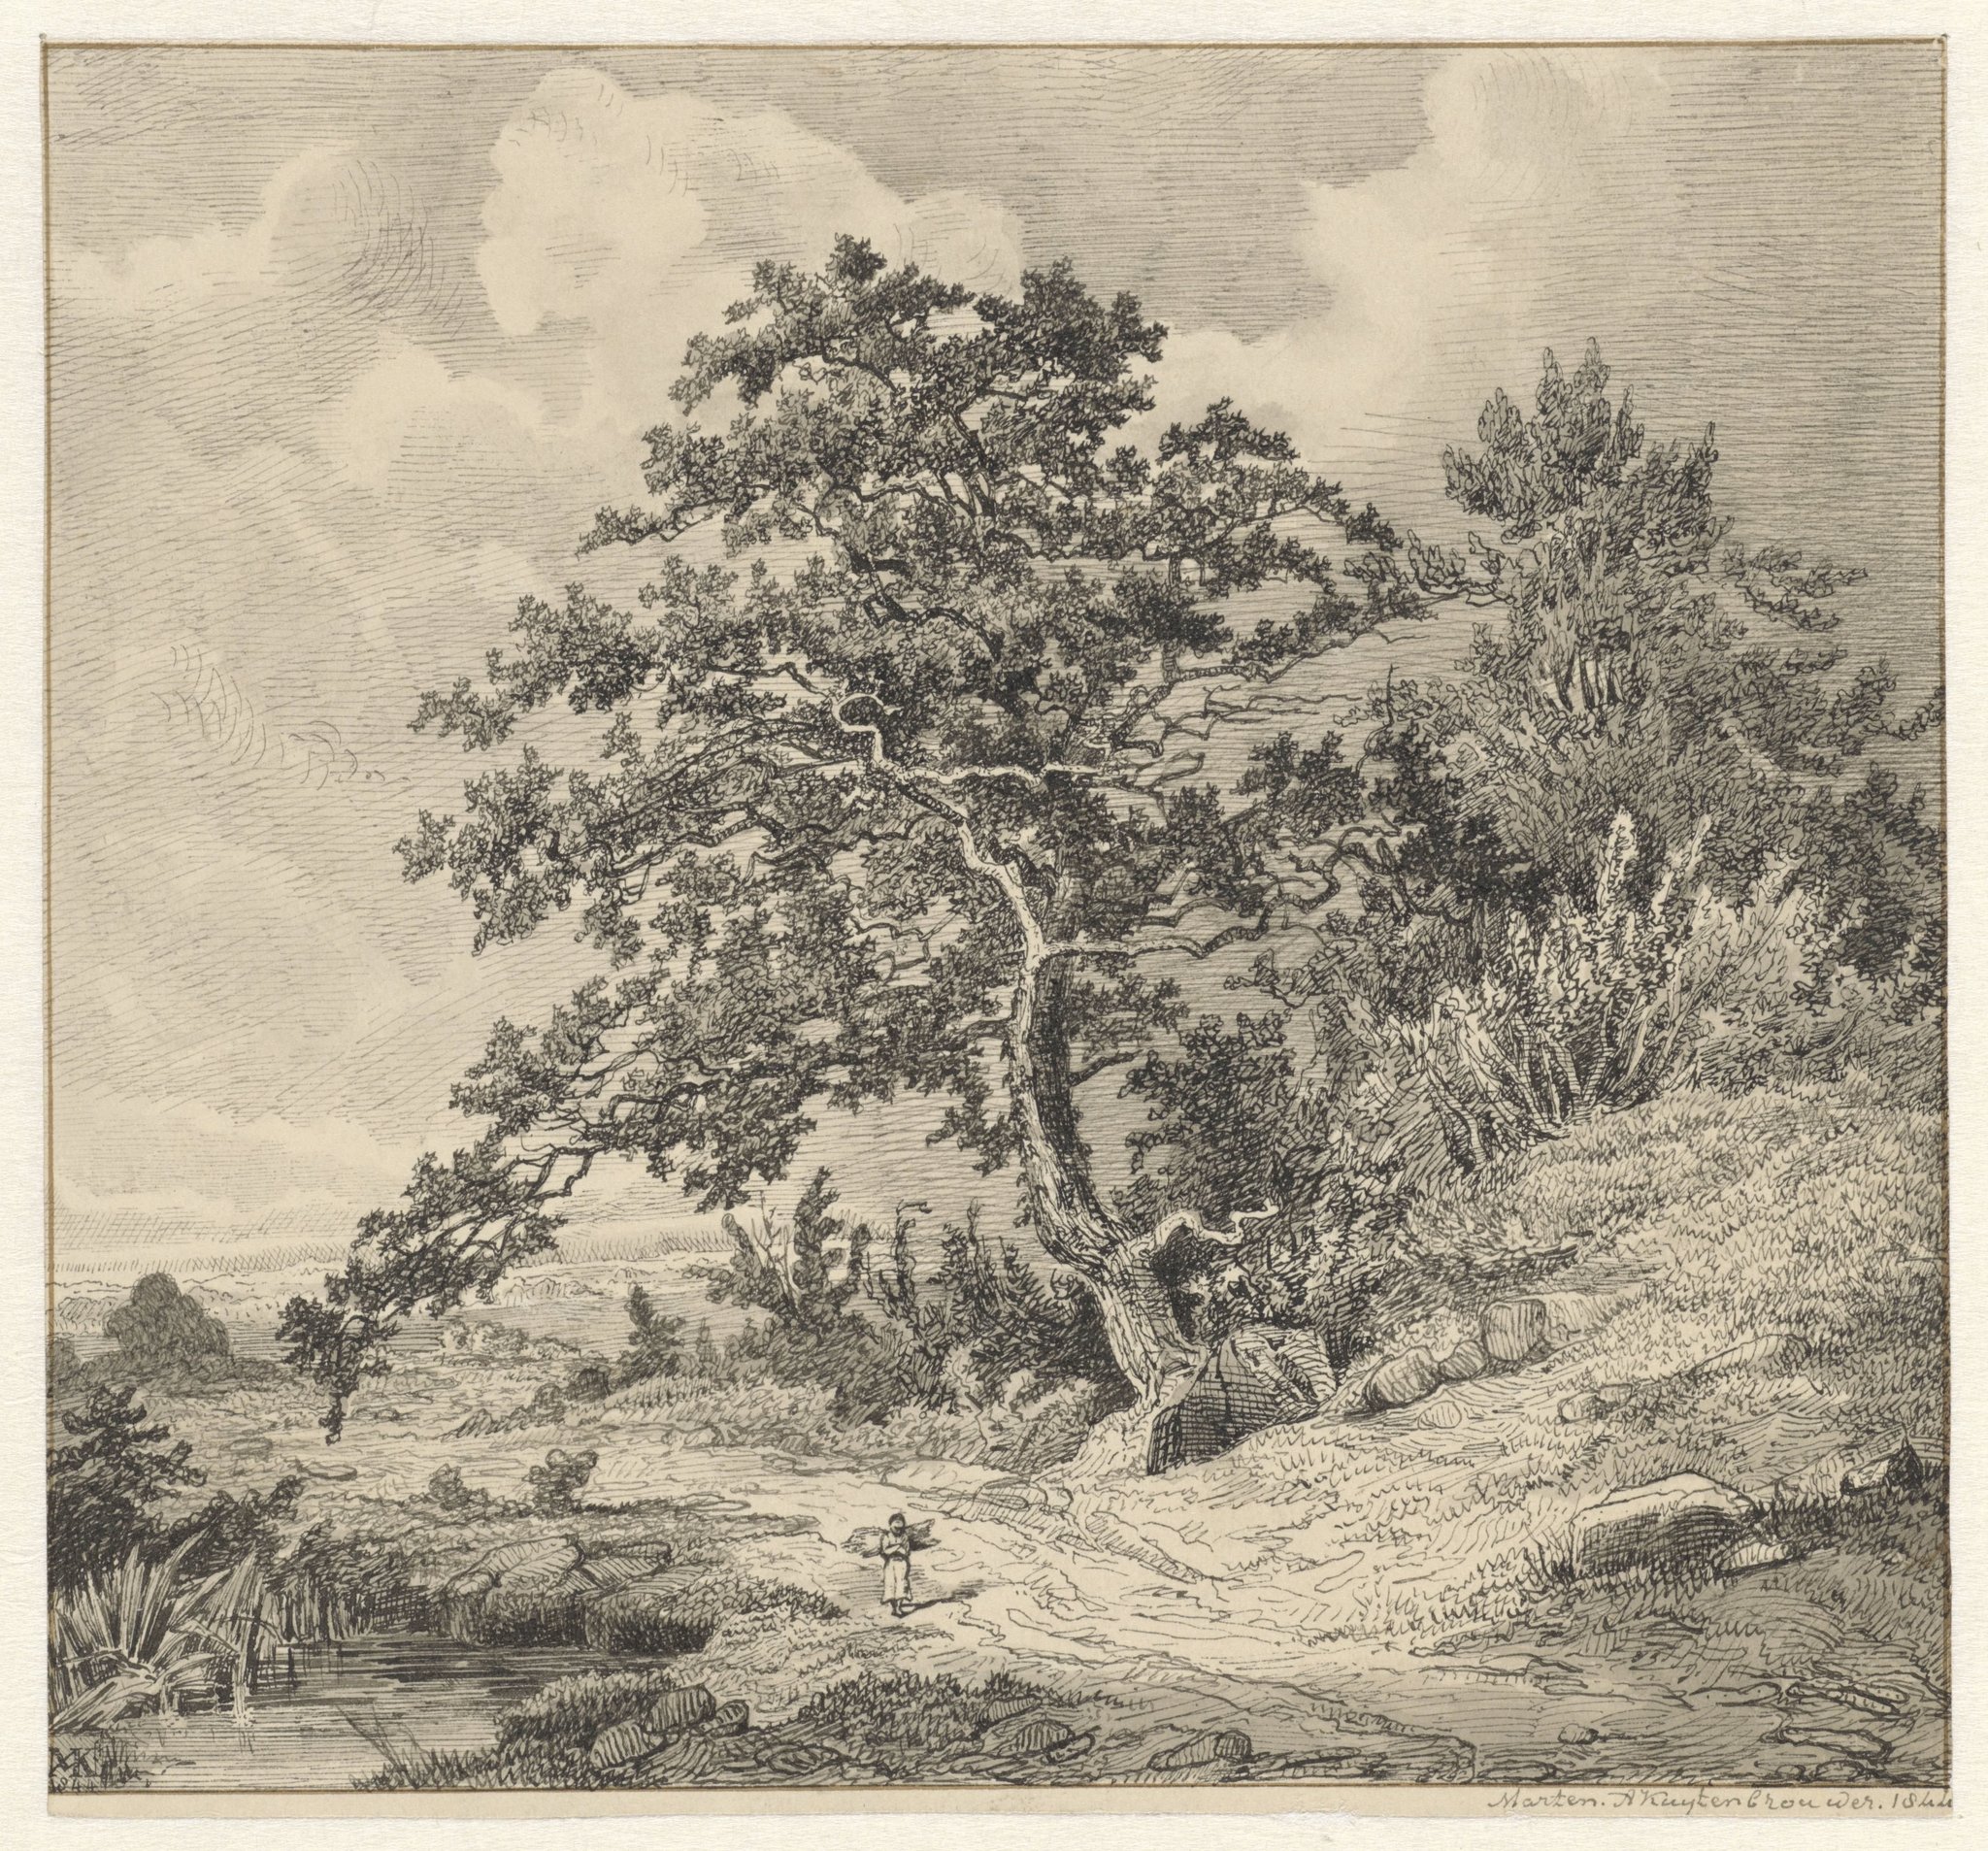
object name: drawing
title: Landschap met boom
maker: martinus antonius kuytenbrouwer jr.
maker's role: draughtsman, painter, print maker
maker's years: 1821-1897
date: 1844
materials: ink, paper, pencil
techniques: brush, pen